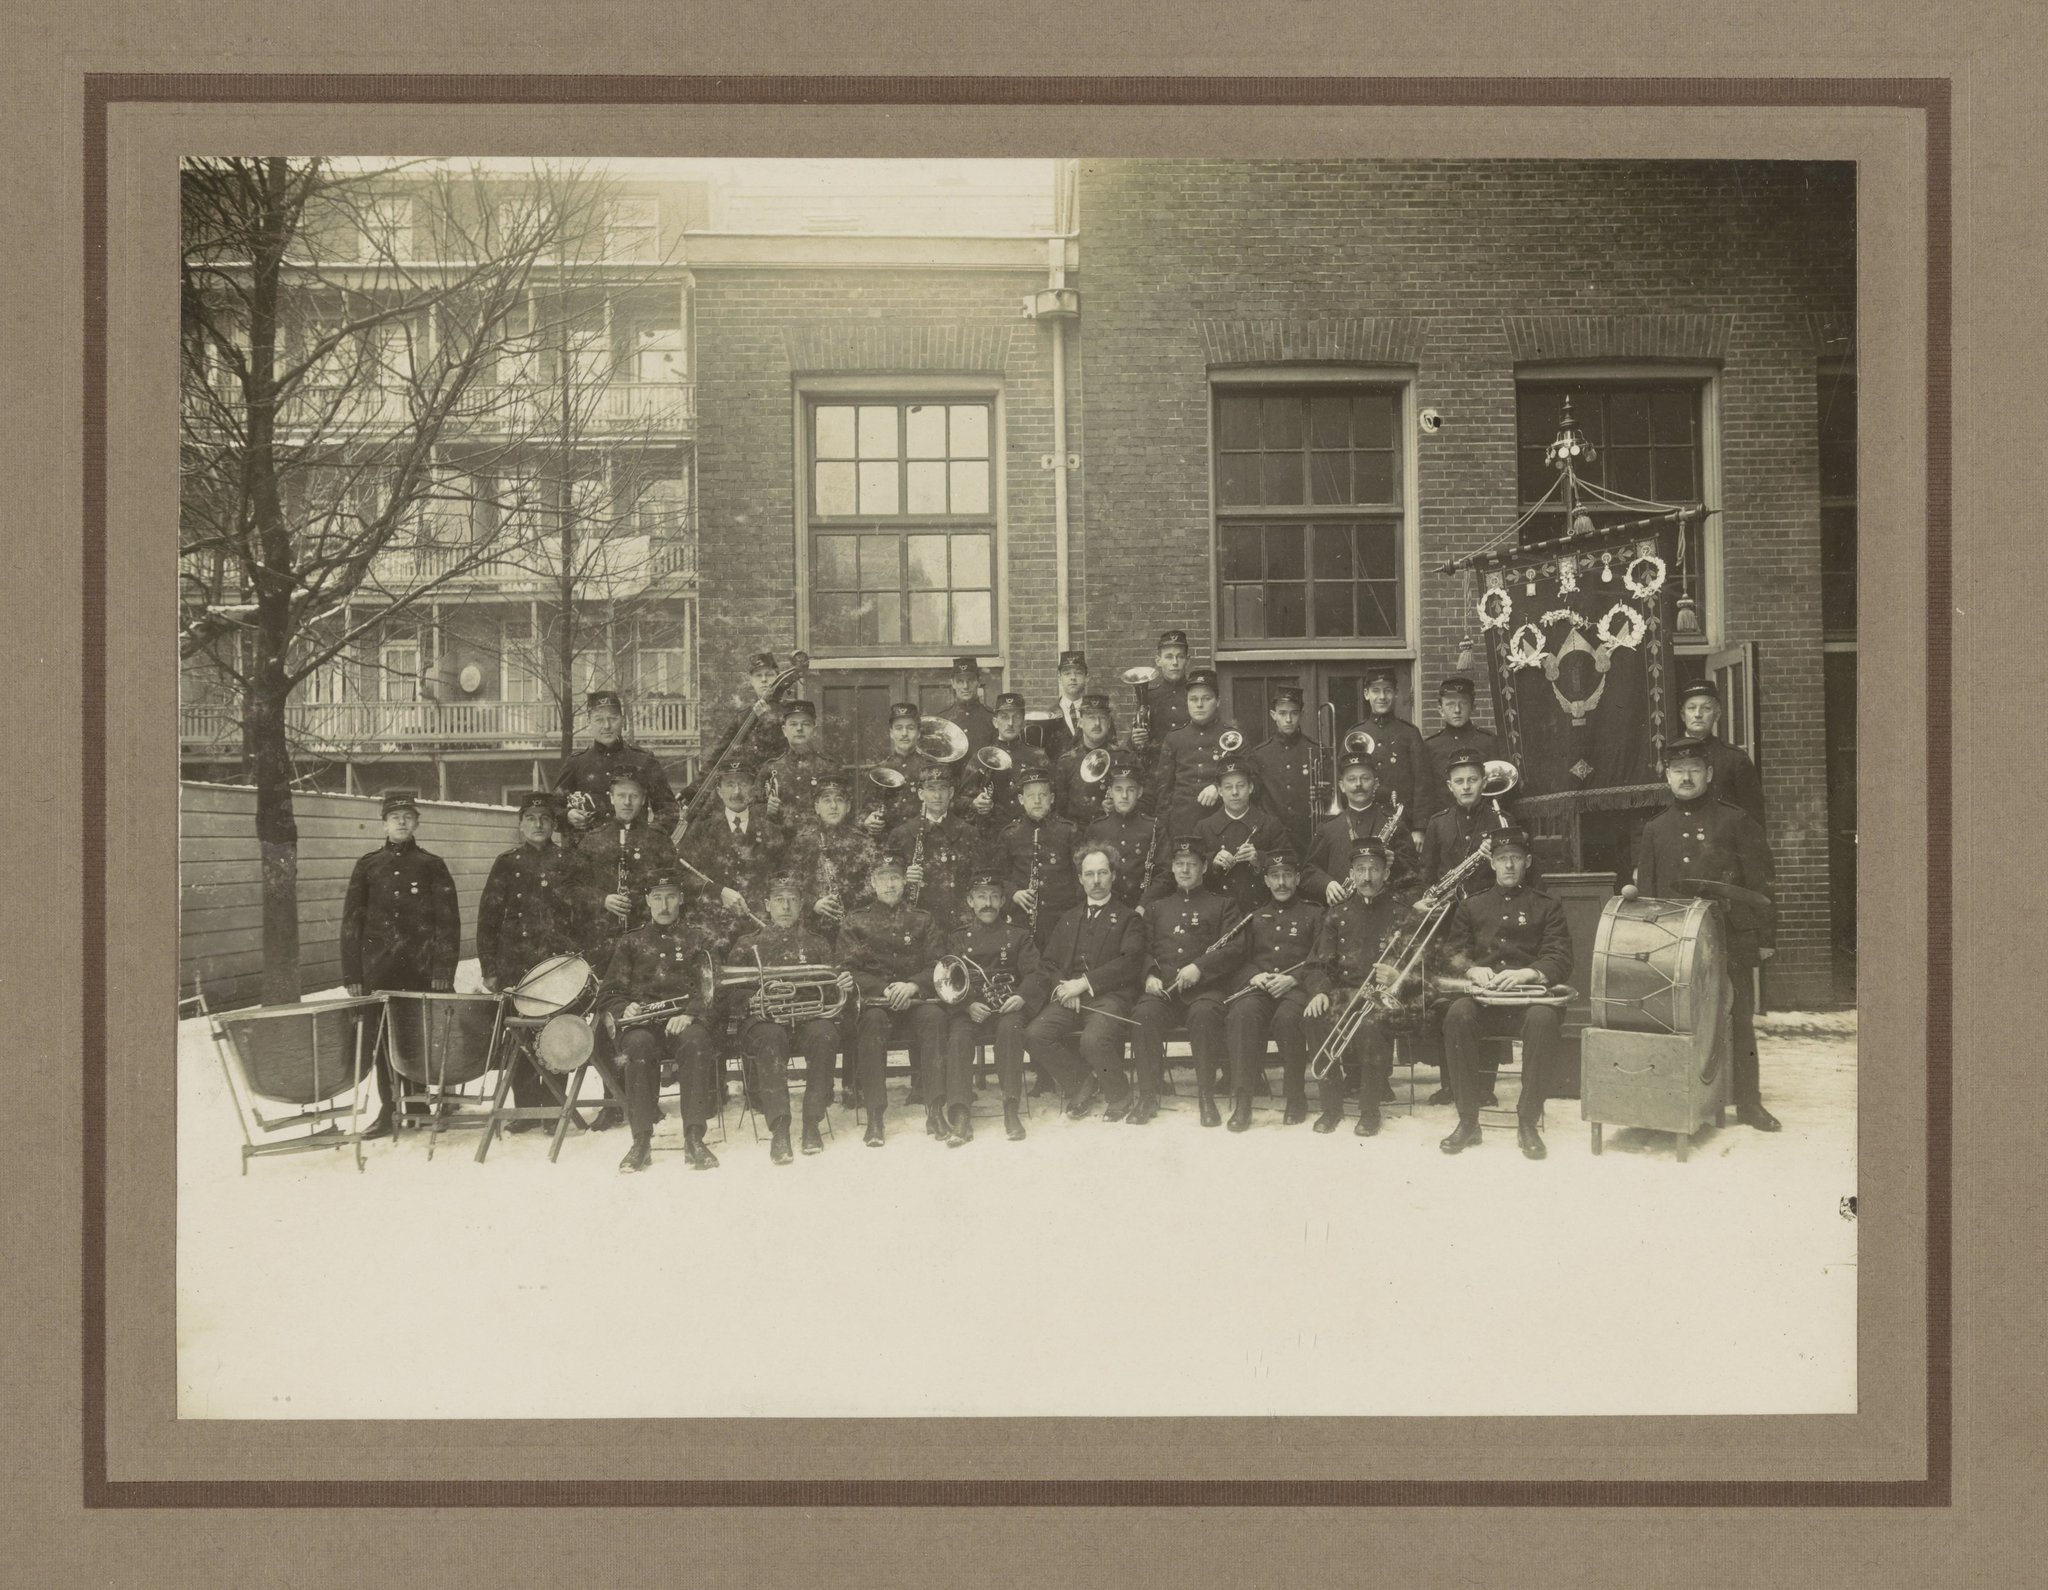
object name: photograph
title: Amsterdamsche Postharmonie, groepsportret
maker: Anonymous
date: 1920-1940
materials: cardboard, photographic support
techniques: gelatin silver print